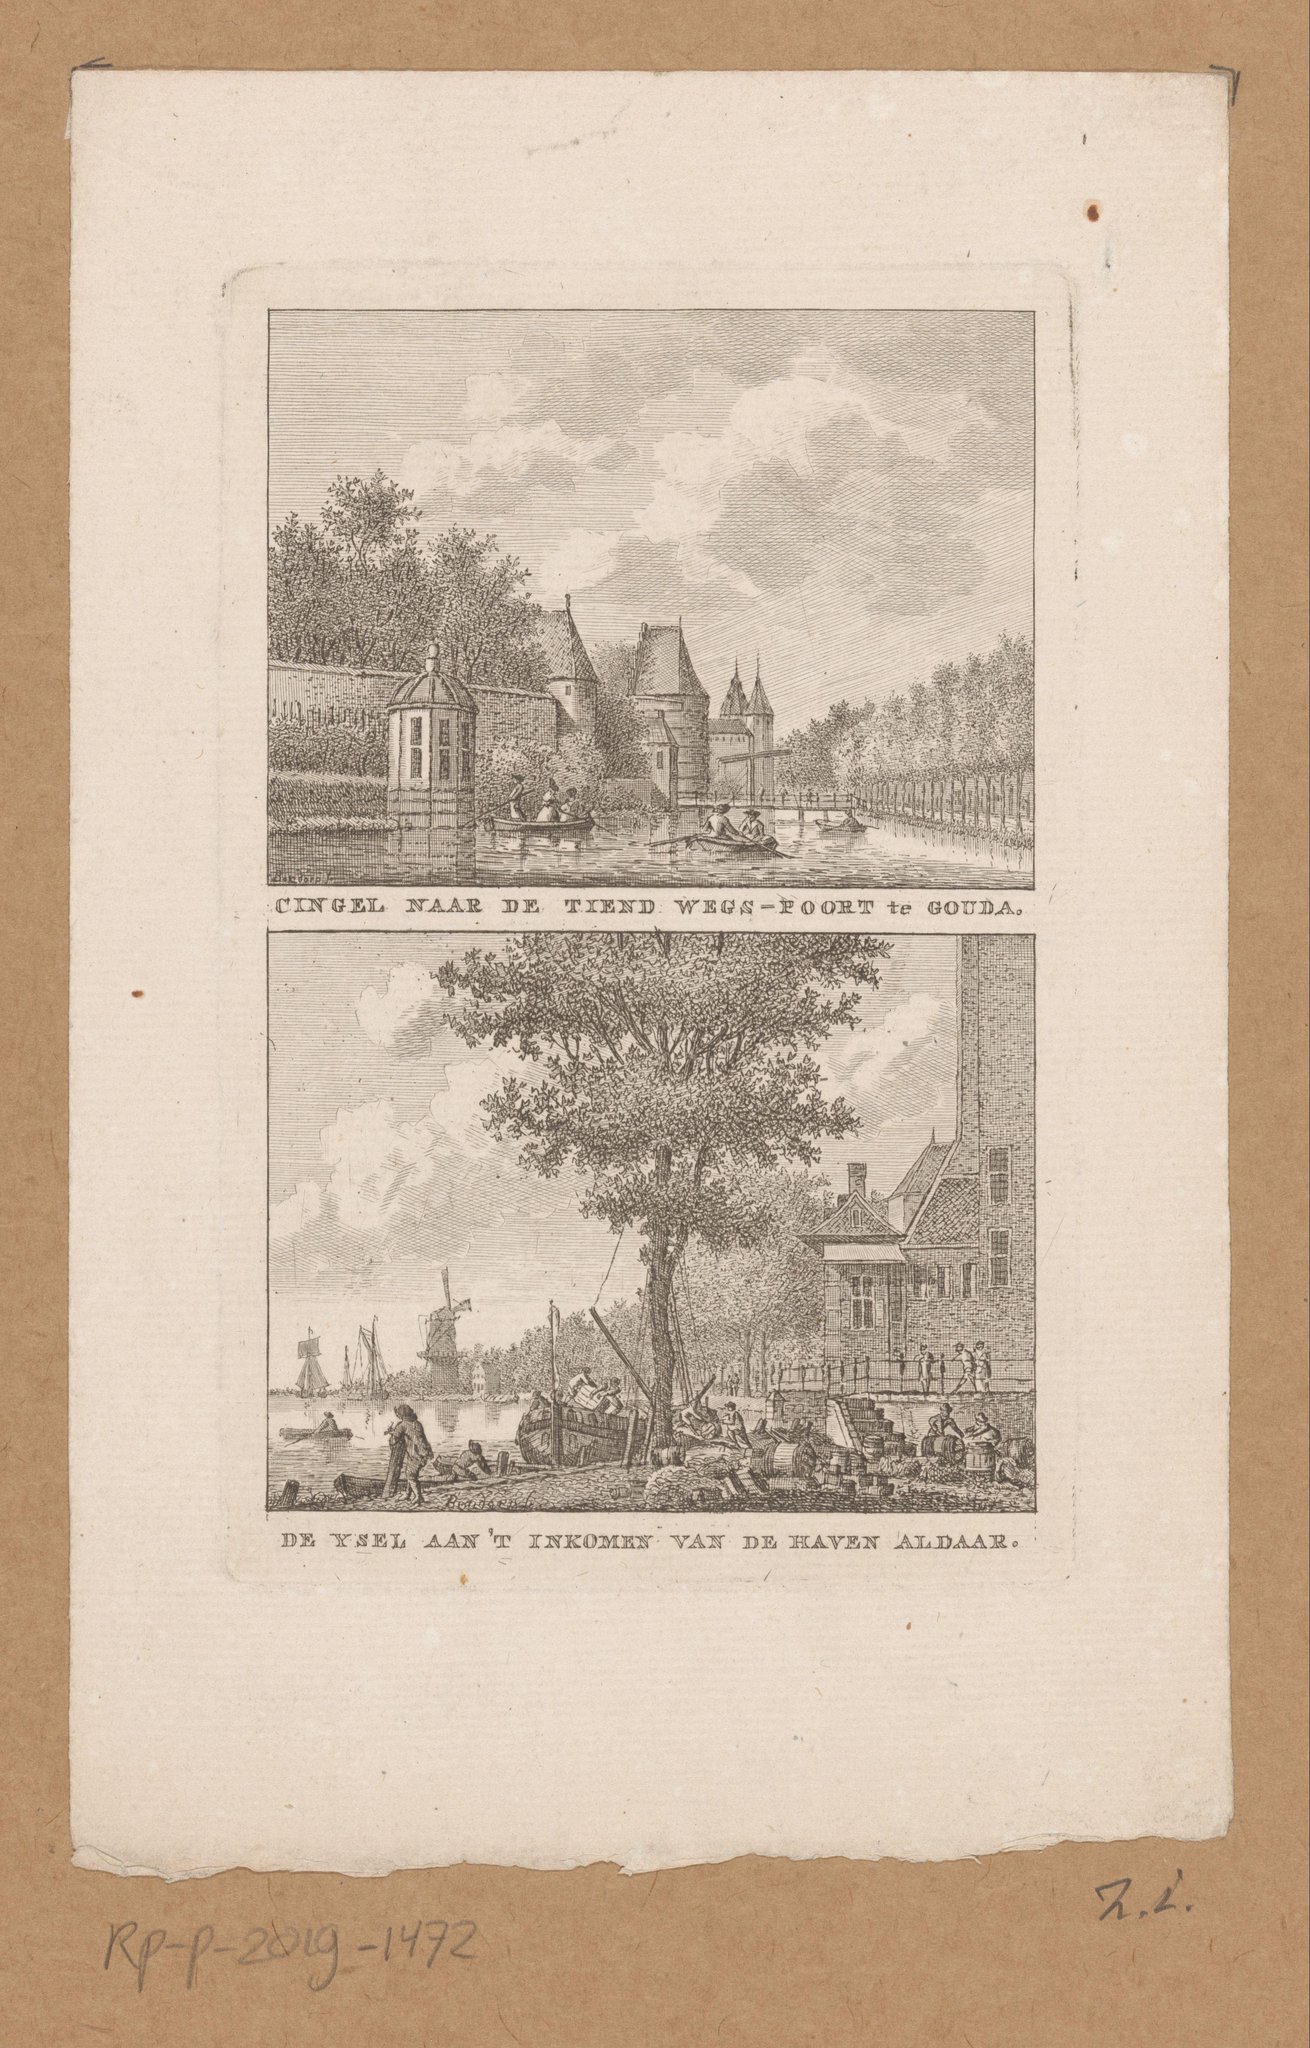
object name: print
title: Cingel naar de Tiend Wegs-Poort te Gouda / De Ysel aan 't inkomen van de haven aldaar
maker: carel frederik bendorp (i)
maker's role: print maker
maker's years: 1736-1814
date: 1786-1792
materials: paper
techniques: etching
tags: city-gate, canals, waters (in city) (+ city(-scape) with figures, staffage), harbour (+ number of persons ~ traffic and transport), gouda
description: Prent uit: Vaderlandsche gezichten, of afbeeldingen van den tegenwoordigen staat der Vereenigde Nederlanden (…). Amsterdam: Hendrik Gartman, Willem Vermandel en Jan Willem Smit, 1786-1792. Uitgegeven in afleveringen met ieder een eigen bifolium en inhoudsopgave. Alle prenten in deze publicatie zijn gegraveerd door Carel Frederik Bendorp (I) en, in de meeste gevallen, gebaseerd op tekeningen van Jan Bulthuis.